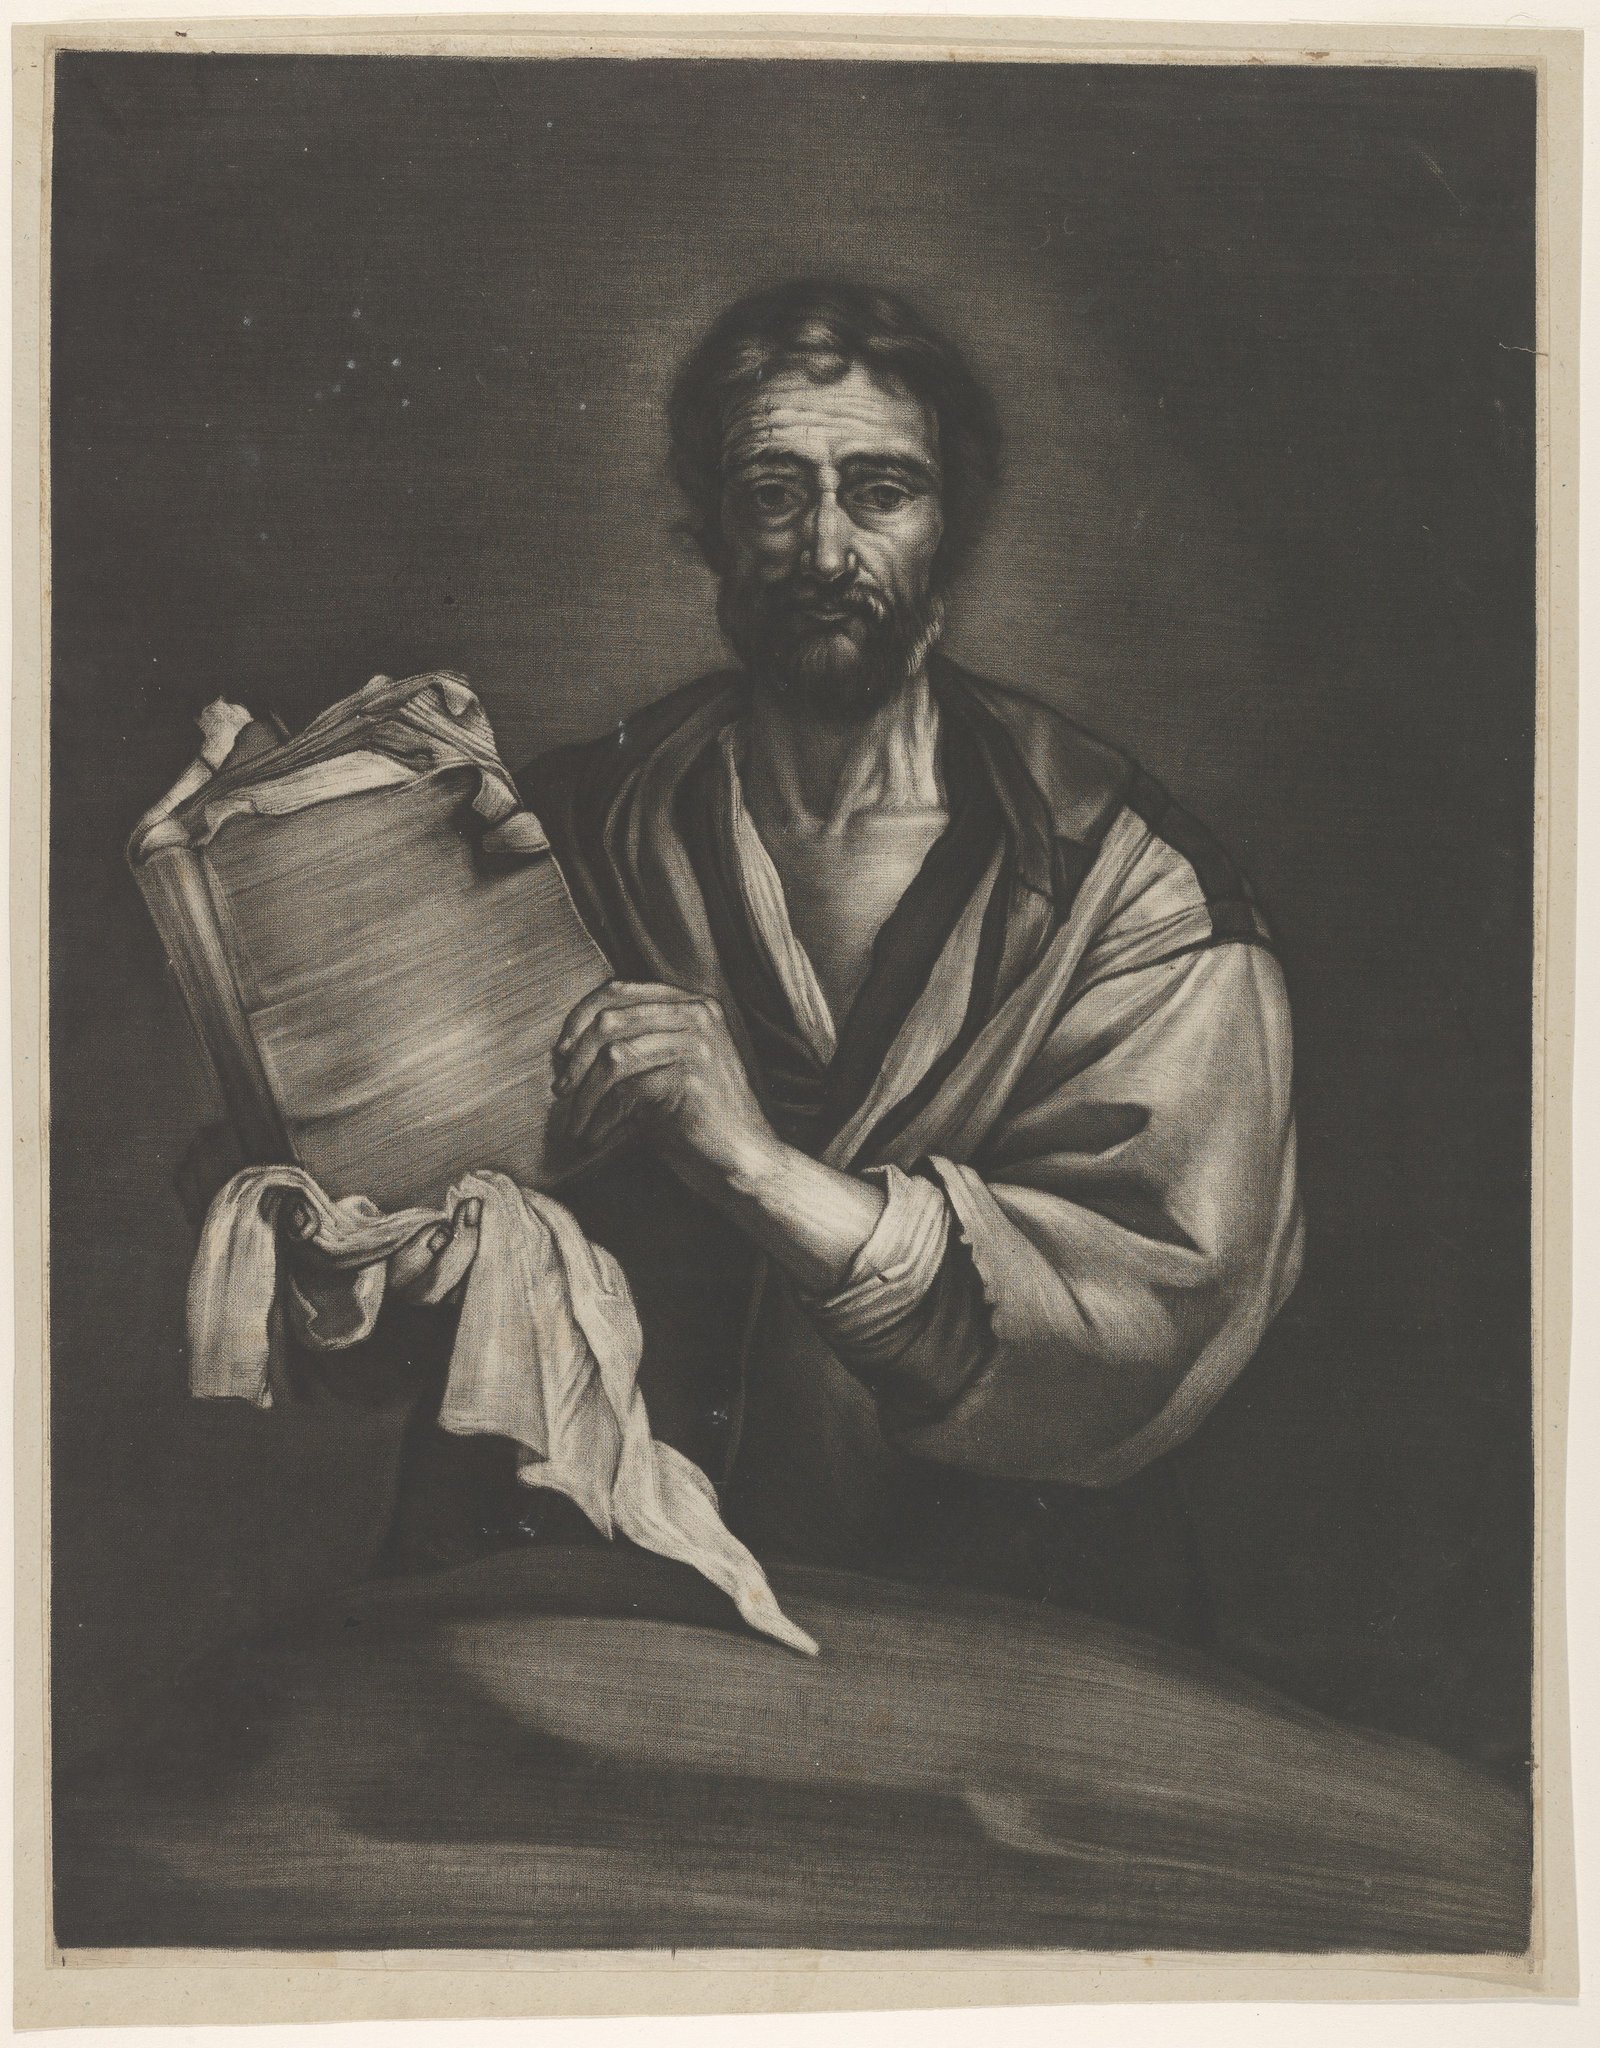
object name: print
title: A Philosopher, looking forward, holding a book with a cloth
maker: bernard vaillant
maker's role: artist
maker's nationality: dutch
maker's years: 1632-1698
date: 1601-1700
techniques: mezzotint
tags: books,men,philosophers